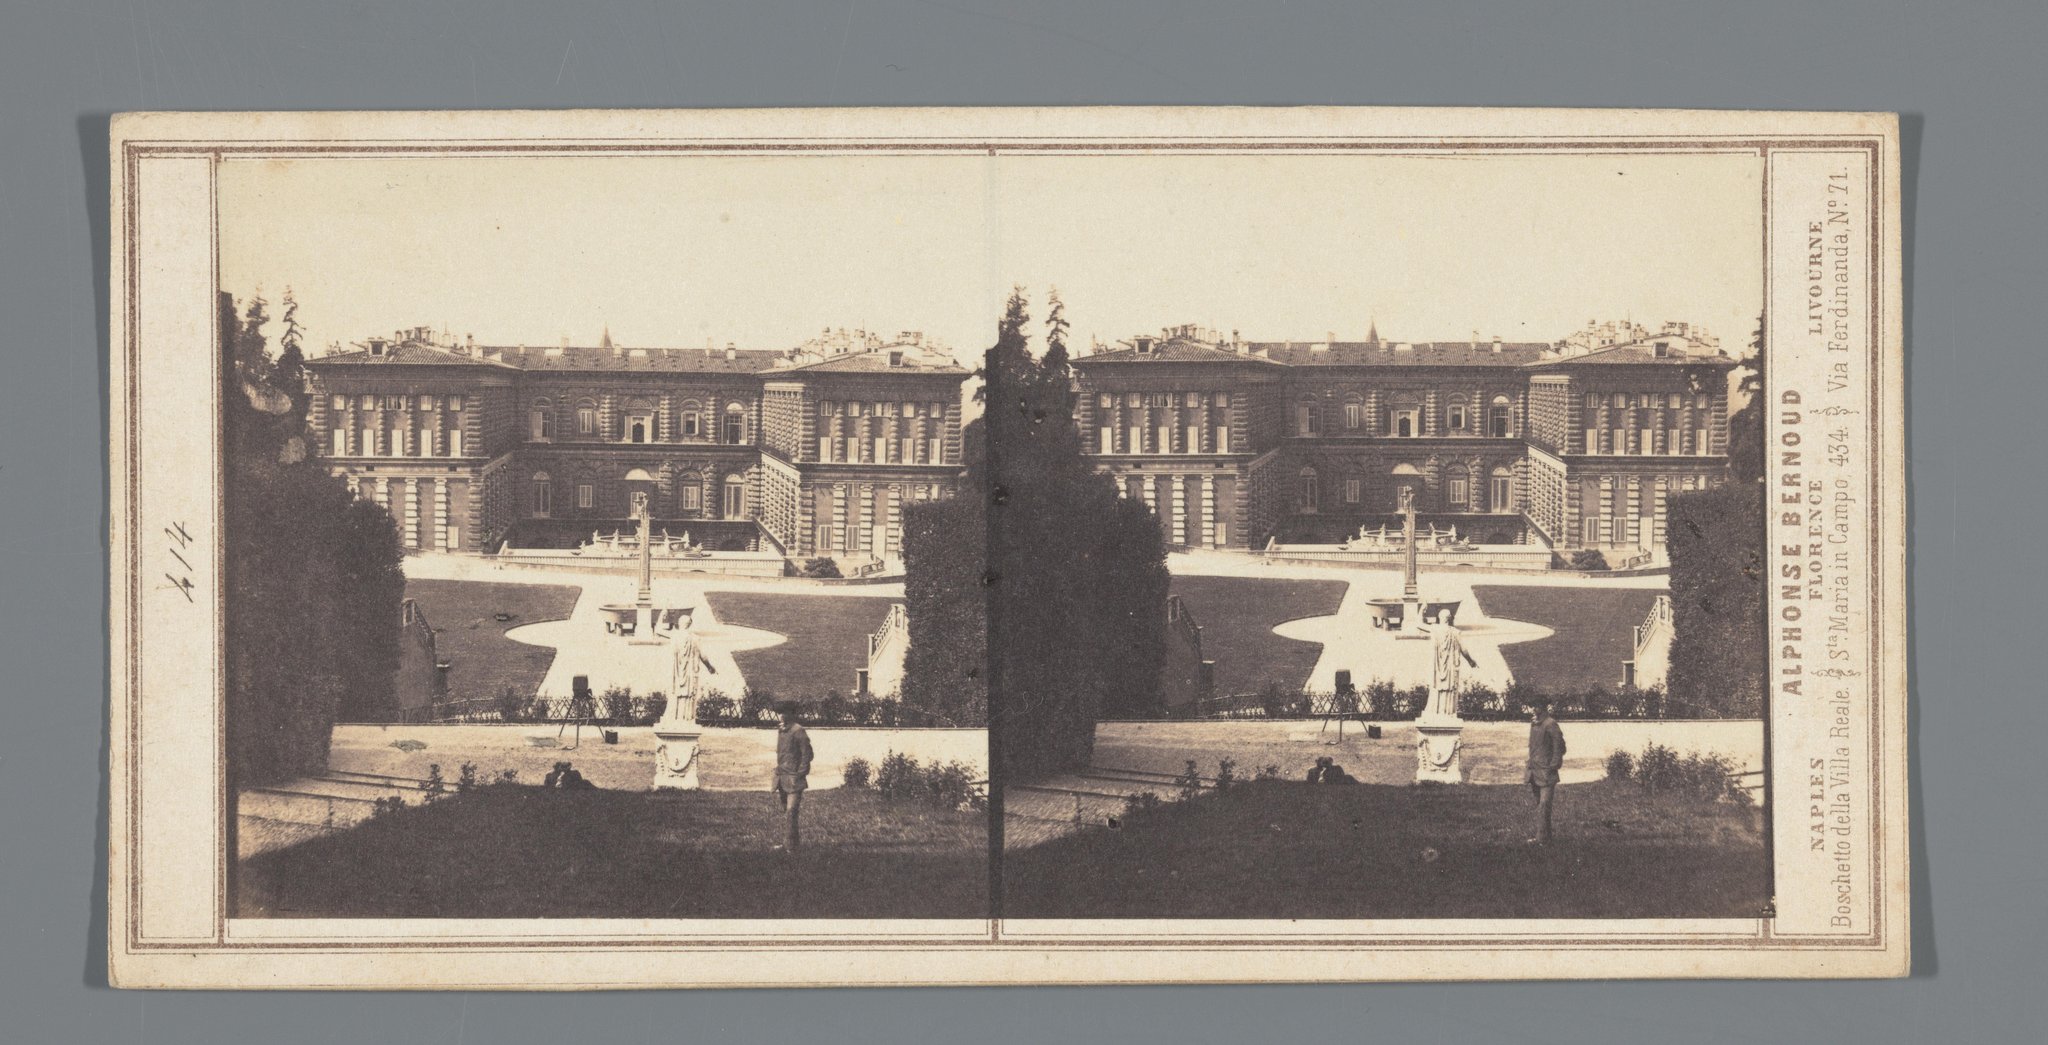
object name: stereograph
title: View of Palazzo Pitti in Florence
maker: alphonse bernoud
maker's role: fotograaf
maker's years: 1820-1889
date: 1860-1865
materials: cardboard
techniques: albumen print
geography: florence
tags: obelisk, needle, palace, photographer at work, façade (of house or building)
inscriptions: inscription: ‘Le palay Pitti vue du Jardin Boboli Florence’, number: ‘414’, name: ‘ALPHONSE BERNOUD NAPLES Boschetto della Villa Reale. FLORENCE Sta Maria in Campo 434. LIVOURNE Via Ferdinanda, No. 71.’